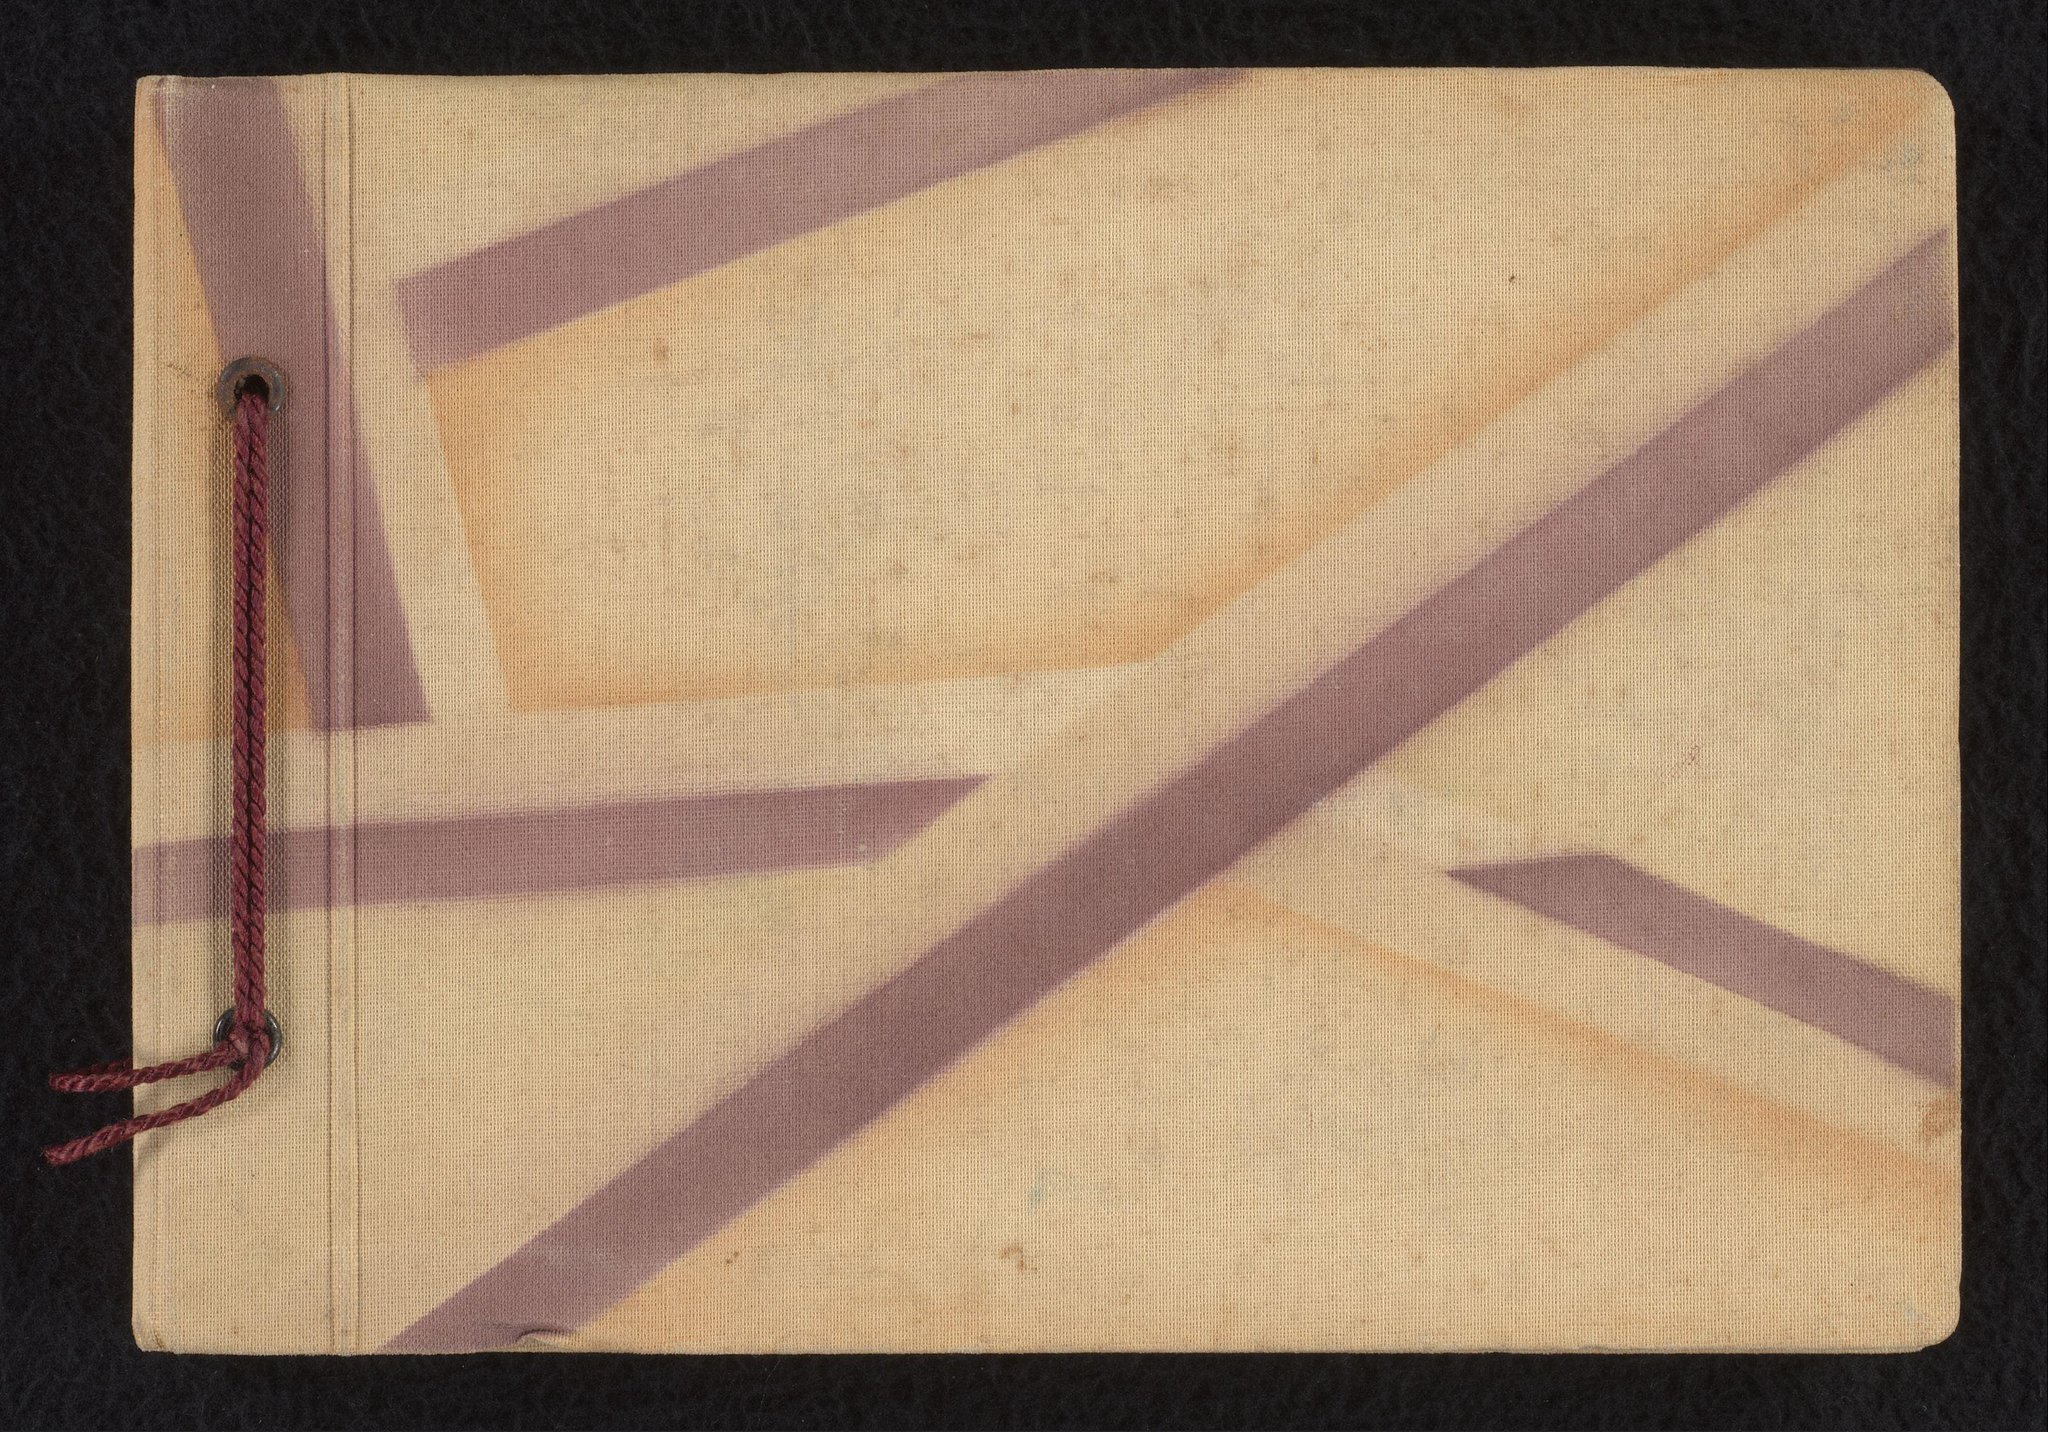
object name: photograph album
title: Fotoalbum met vakantiefoto's en andere foto's uit de privé-sfeer van de familie Wachenheimer, genomen tussen maart 1931 en augustus 1932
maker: Anonymous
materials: cardboard, textile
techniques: gelatin silver print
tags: eugen wachenheimer, else wachenheimer-moos, isabel wachenheimer-elon, willy moos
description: bijschriften geschreven in het handschrift van Else Wachenheimer-Moos. Dit object is onderdeel van de nalatenschap van Isabel Elon-Wachenheimer (1928-2010). Tot haar overlijden behoorde het samen met de andere objecten uit de nalatenschap tot haar privédomein van Isabel Wachenheimer. In die particuliere context zijn deze objecten tezamen en individueel aandenkens - aan de jeugd, ouders en familie van Isabel Wachenheimer vóór en tijdens de Shoah en aan haar leven na de Tweede Wereldoorlog. Isabel Wachenheimer, die van juni 1943 tot mei 1945 gevangen zat in Kamp Westerbork, Theresienstadt, Auschwitz, Lenzing a/d Oberdonau (een buitenkamp van Mauthausen), overleefde de Shoah. Haar ouders – Eugène Wachenheimer en Else Wachenheimer-Moos - werden op 14 oktober 1944 in Auschwitz-Birkenau vermoord.